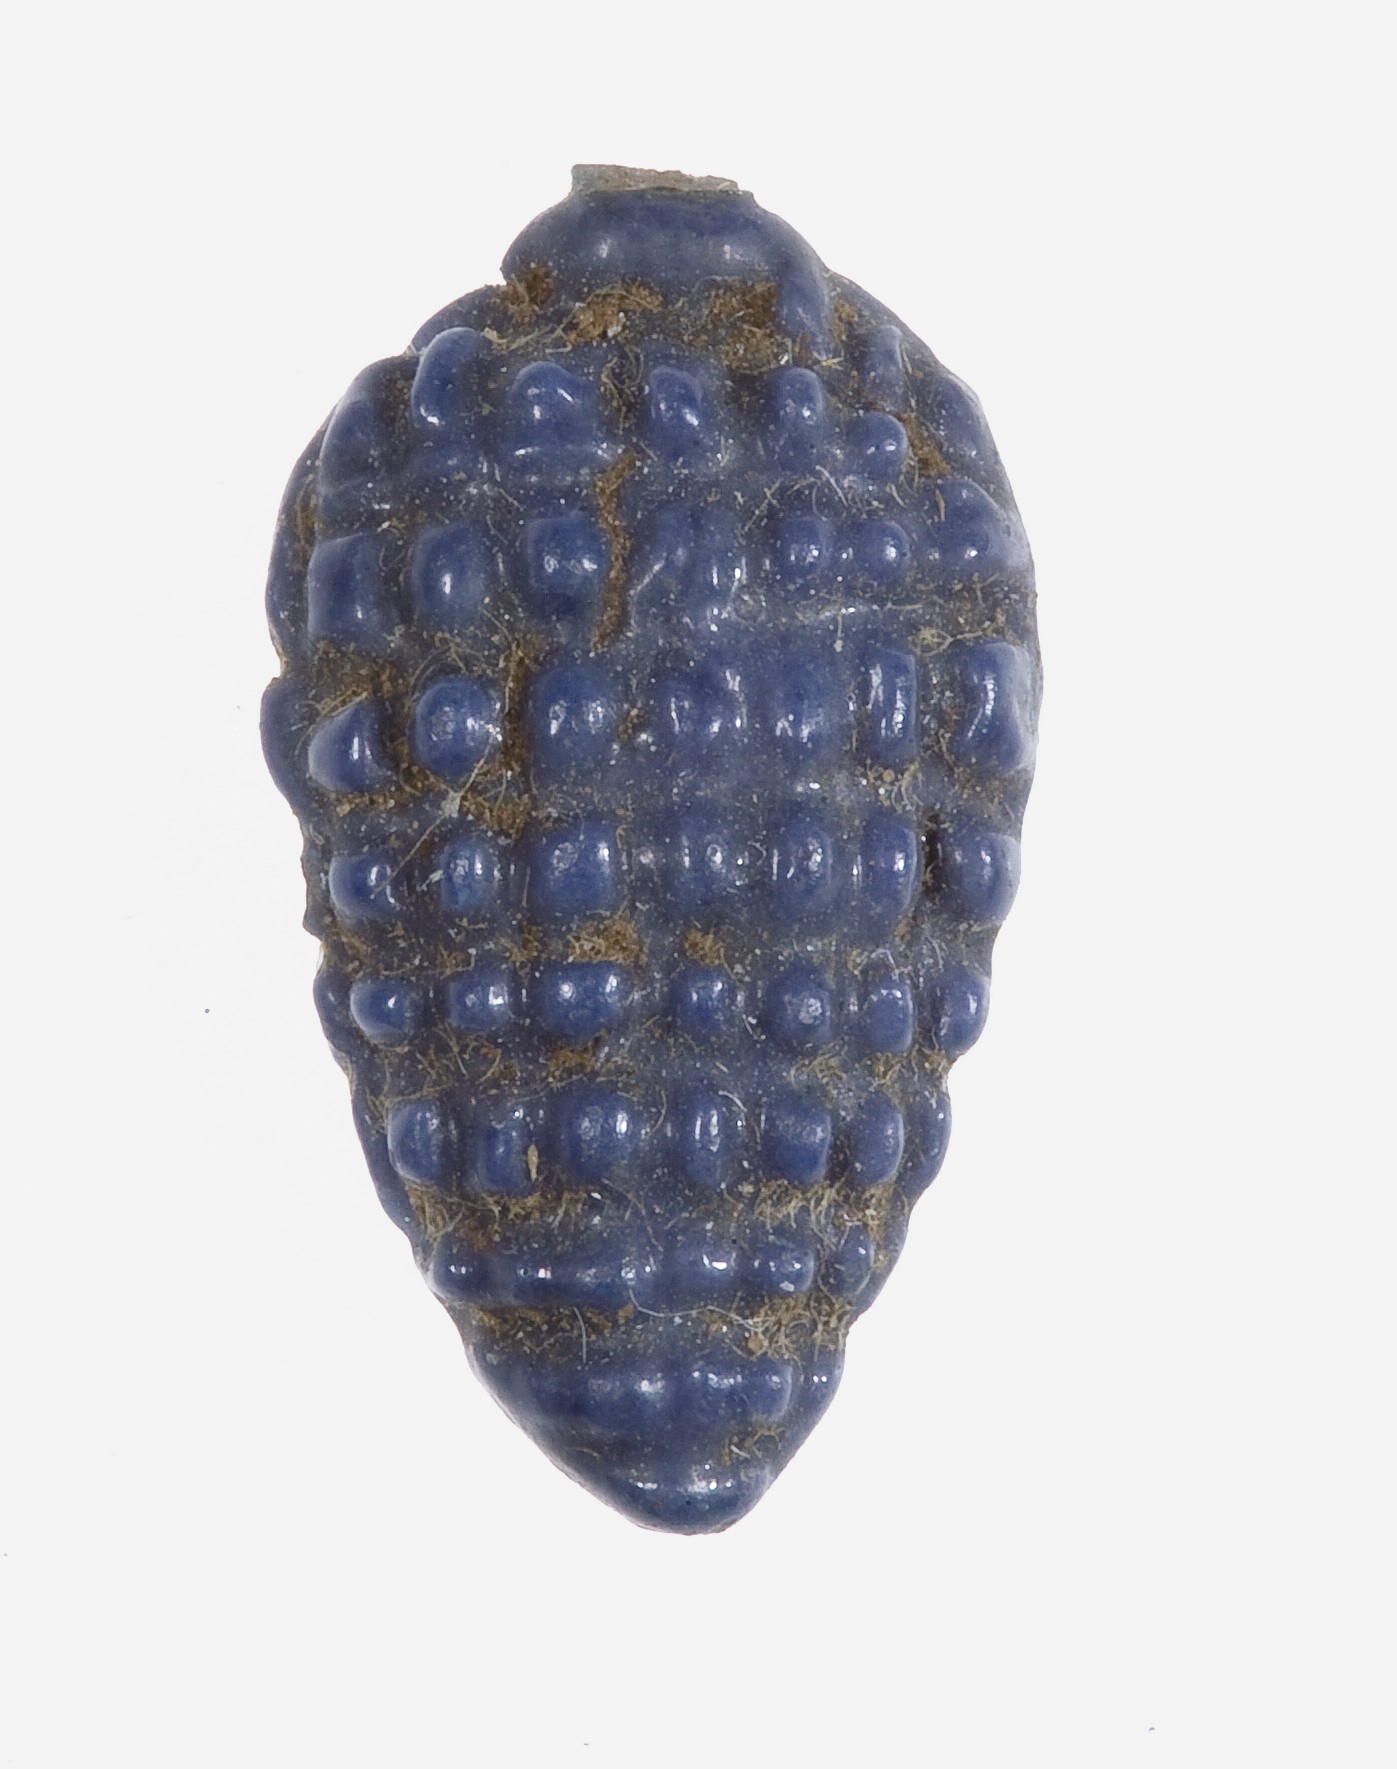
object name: pendant, grape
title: Pendant: Bunch of Grapes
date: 1390-1352 BCE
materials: faience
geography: egypt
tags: grapes